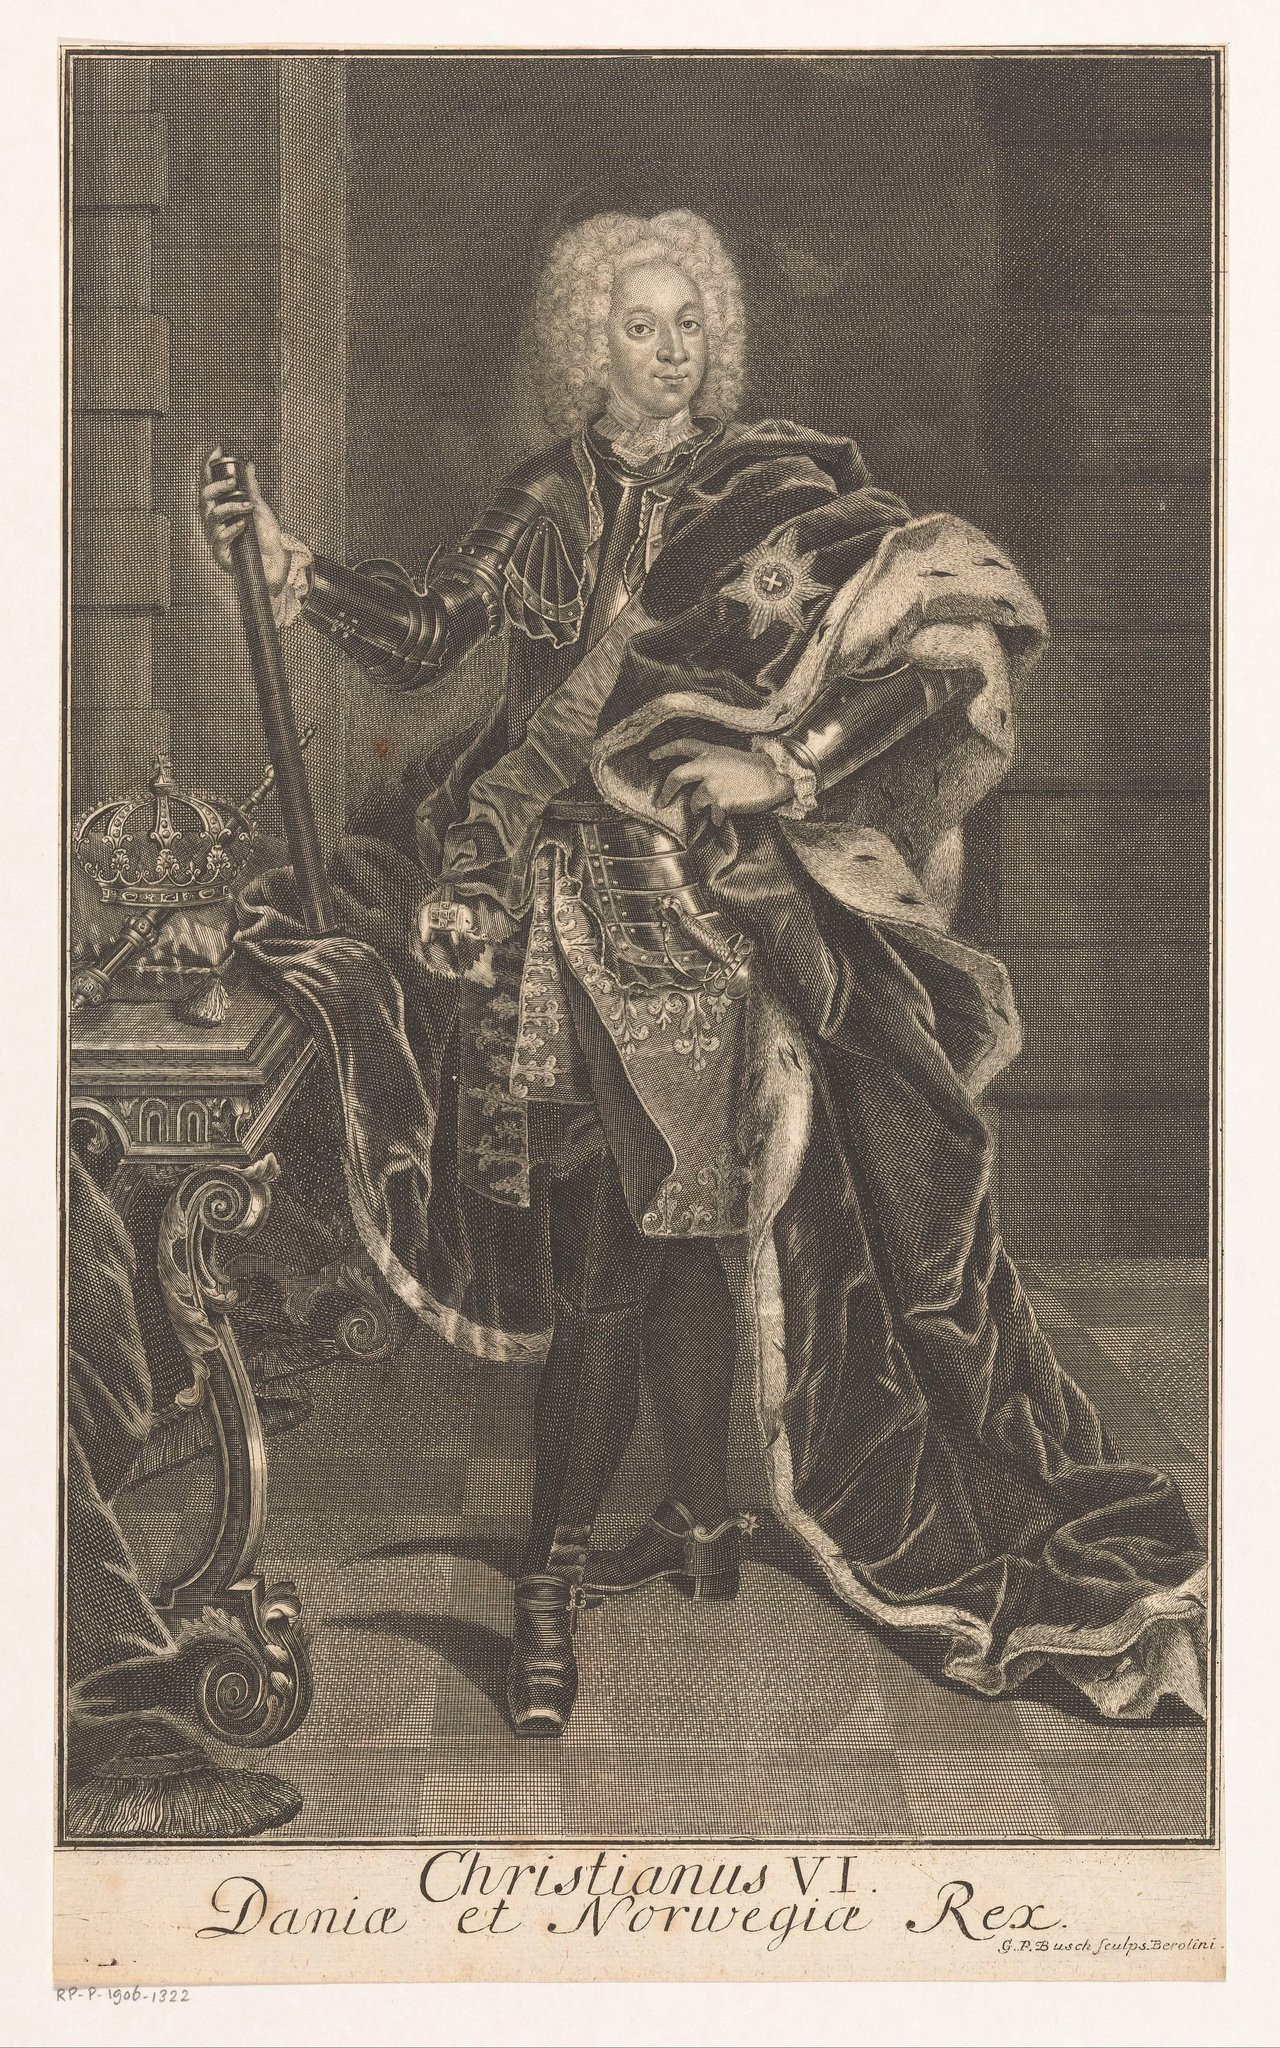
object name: print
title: Portret van Christaan VI, koning van Denemarken en Noorwegen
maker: georg paul busch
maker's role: print maker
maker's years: -1756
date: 1730-1756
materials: paper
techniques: engraving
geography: berlin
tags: copenhagen (city), knighthood order, armour, historical persons, baton of general, insignia and symbols of sovereignty (crown, diadem, sceptre, orb, seal, standard, cloak, pectoral)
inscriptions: collector's mark: Lugt 2228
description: Geportretteerd met de versierselen van de Orde van de Olifant.